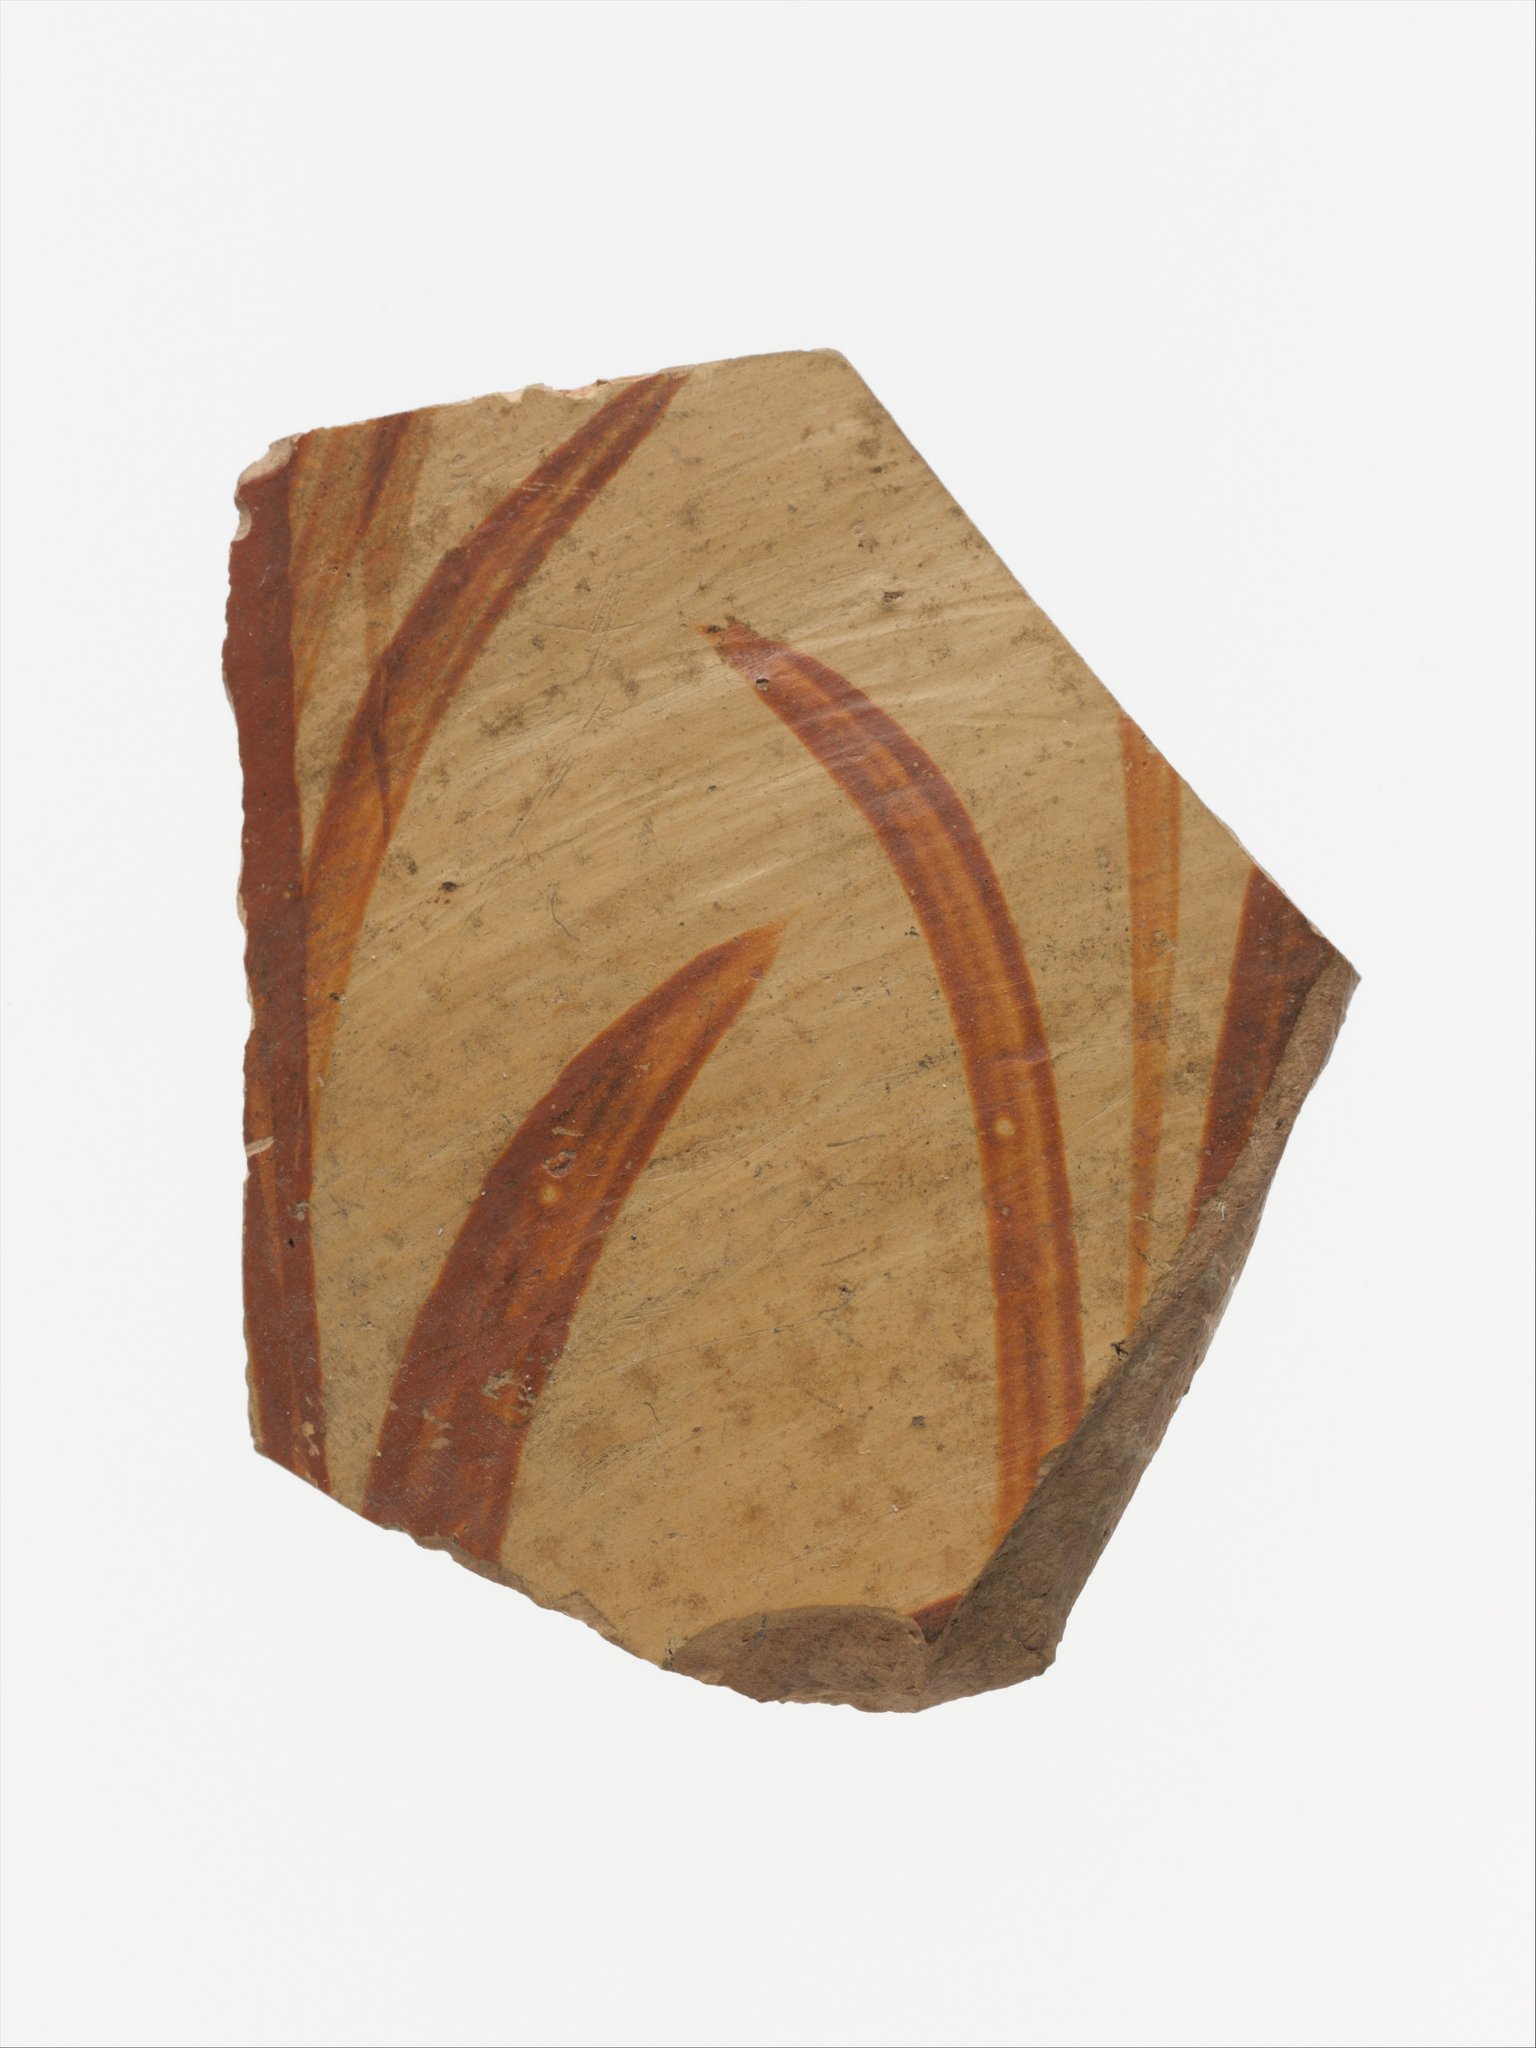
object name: vase fragment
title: Terracotta vessel fragment with grass motif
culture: minoan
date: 1600-1450 BCE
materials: terracotta